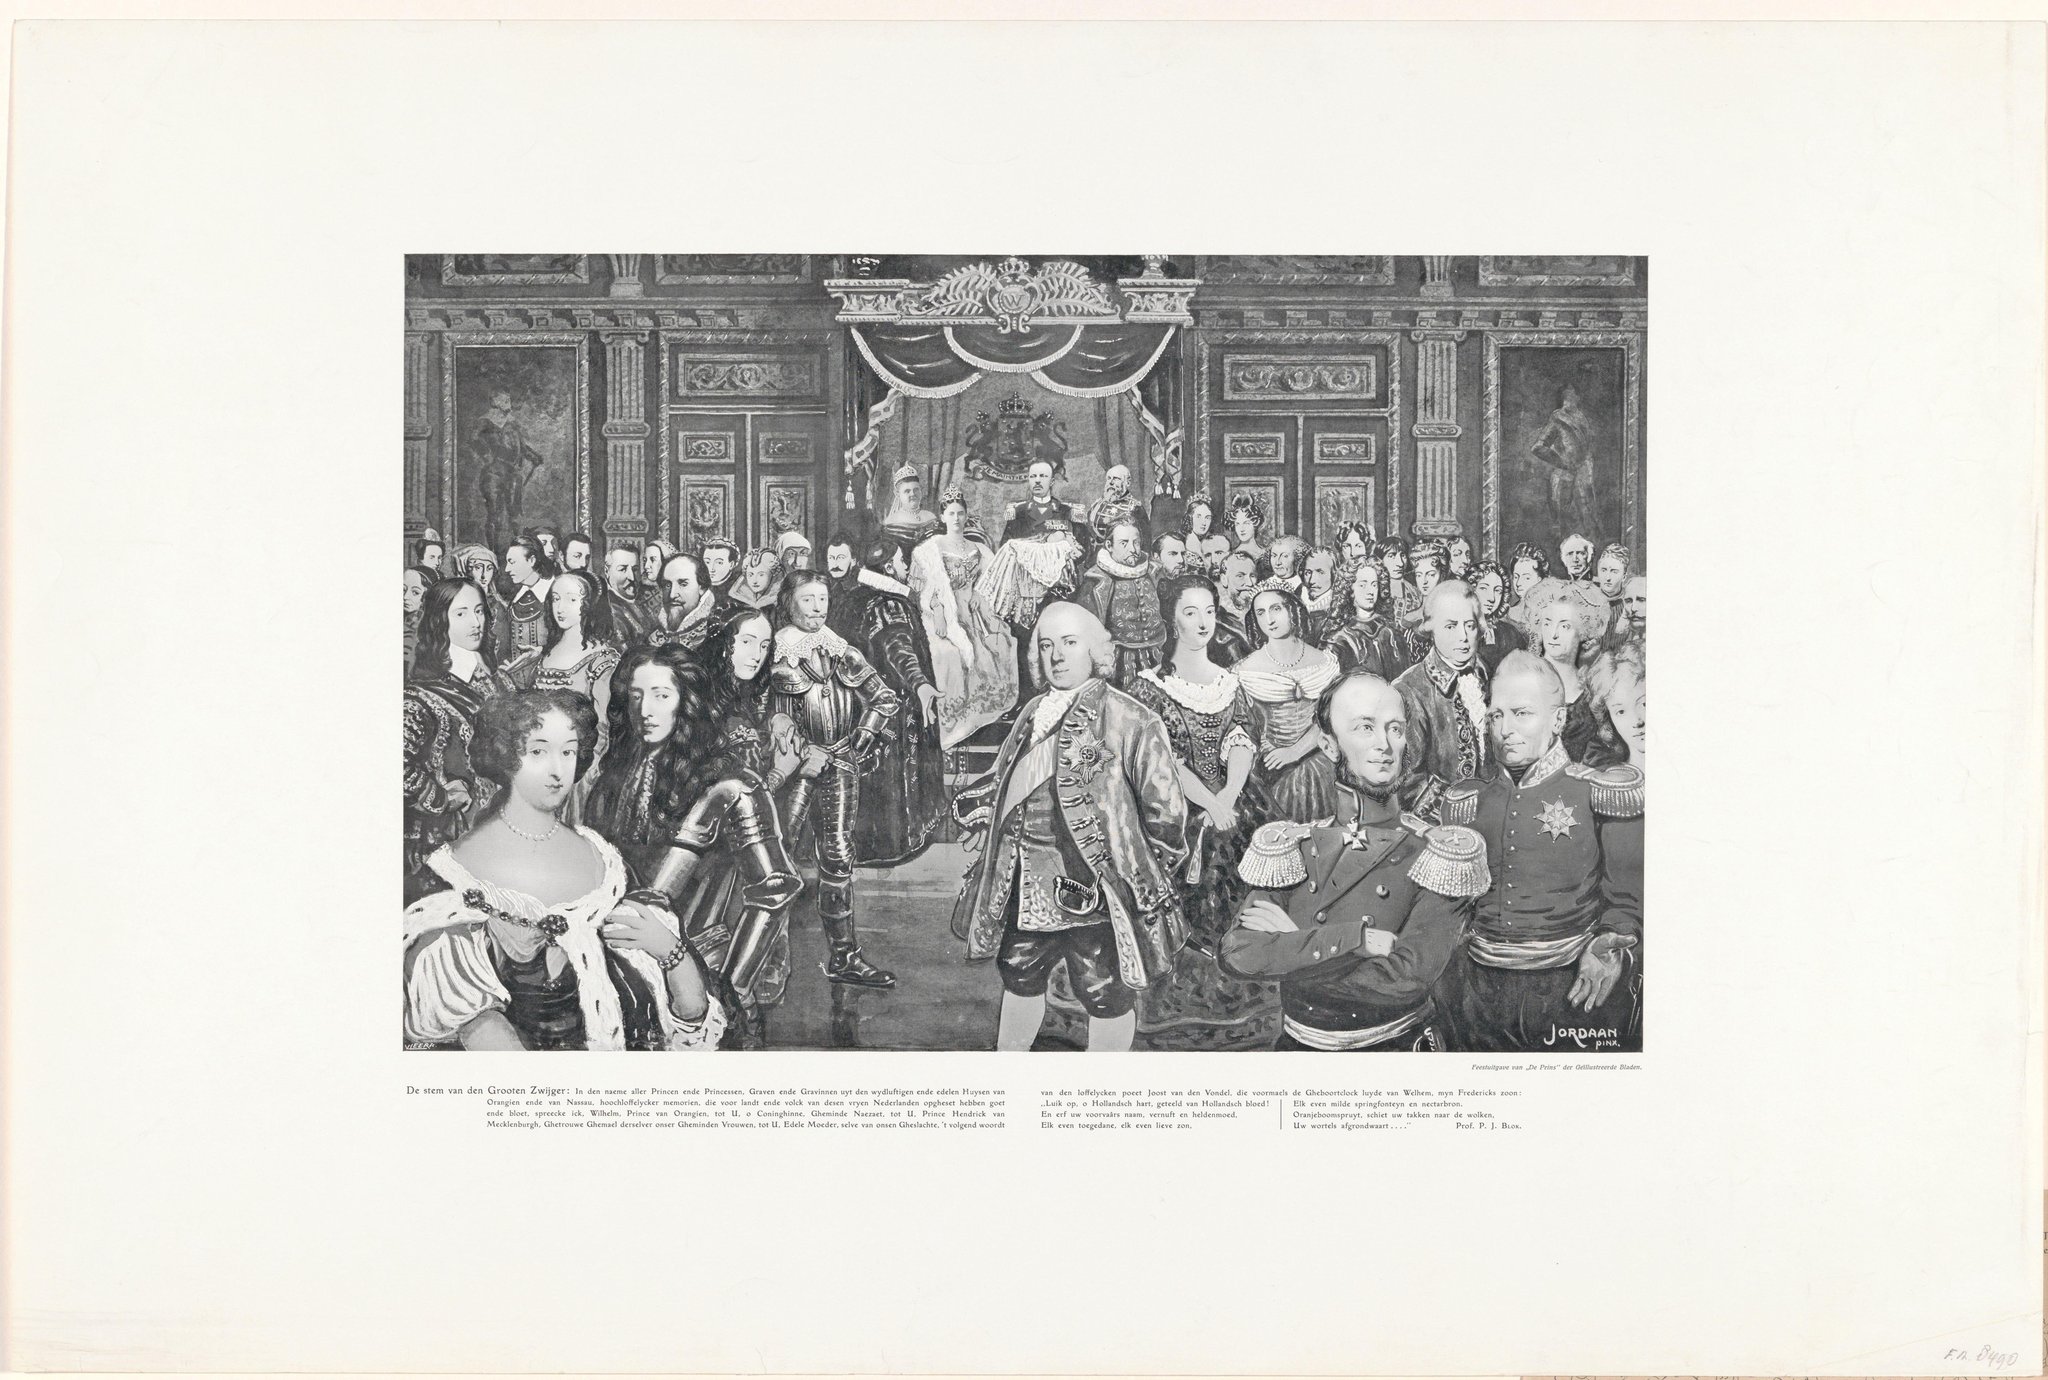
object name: reproduction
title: Feestuitgave bij de geboorte van prinses Juliana van "De Prins" der Geïllustreerde Bladen, 1909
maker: leendert jurriaan jordaan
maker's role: illustrator, karikaturist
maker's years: 1885-1980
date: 1909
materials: paper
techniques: printing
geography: netherlands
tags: the hague, print maker, wilhelmina of the netherlands, hendrik (prins der nederlanden (1876-1934)), juliana of the netherlands, family group, especially parents with their child(ren), mother and baby or young child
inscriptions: collector's mark: Lugt 2228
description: Feestuitgave van "De Prins" der Geïllustreerde Bladen ter gelegenheid van de geboorte van prinses Juliana op 20 april 1909. De leden van het geslacht Oranje-Nassau bijeen in een zaal waarbij Willem van Oranje namens allen een groet brengt aan Koningin Wilhelmina en Prins Hendrik. Met onderschrift. Bij de prent behoort een sleutel met de namen van alle voorgestelden.